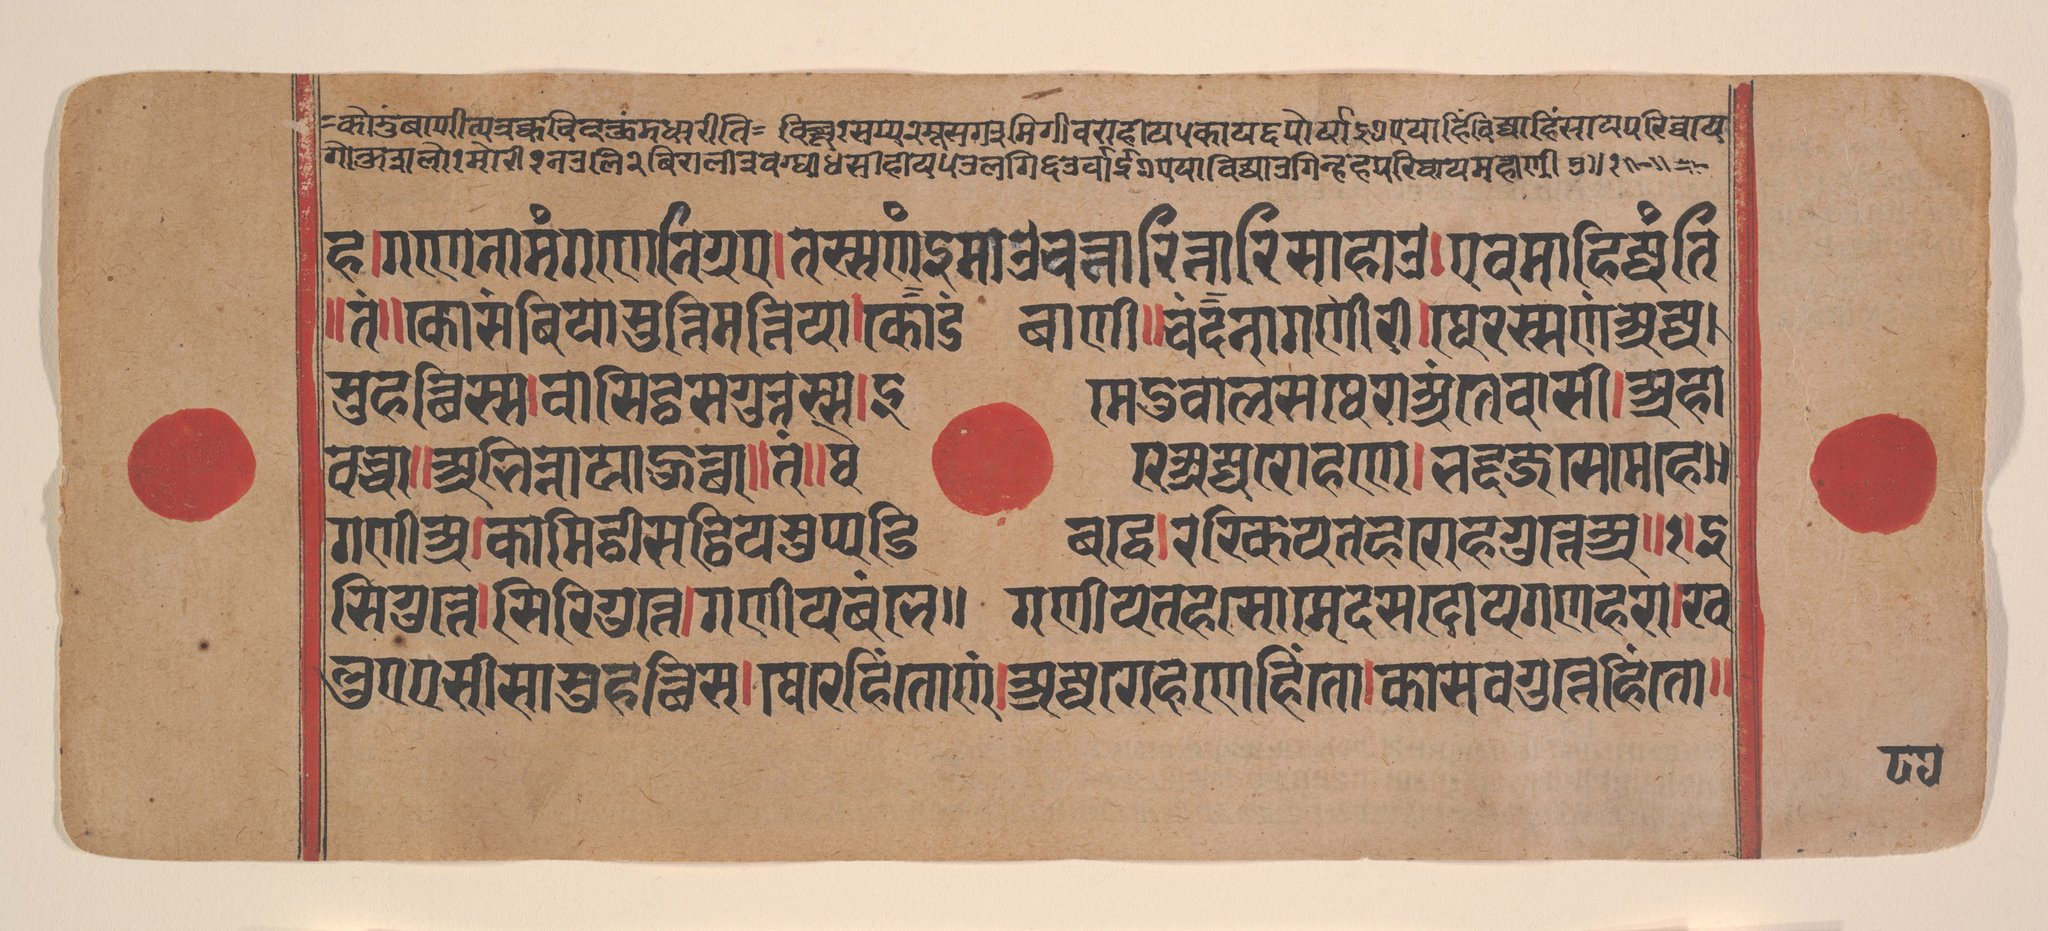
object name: folio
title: Page from a Dispersed Kalpa Sutra (Jain Book of Rituals)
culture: indian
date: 1401-1500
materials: gold, ink, paper, watercolor